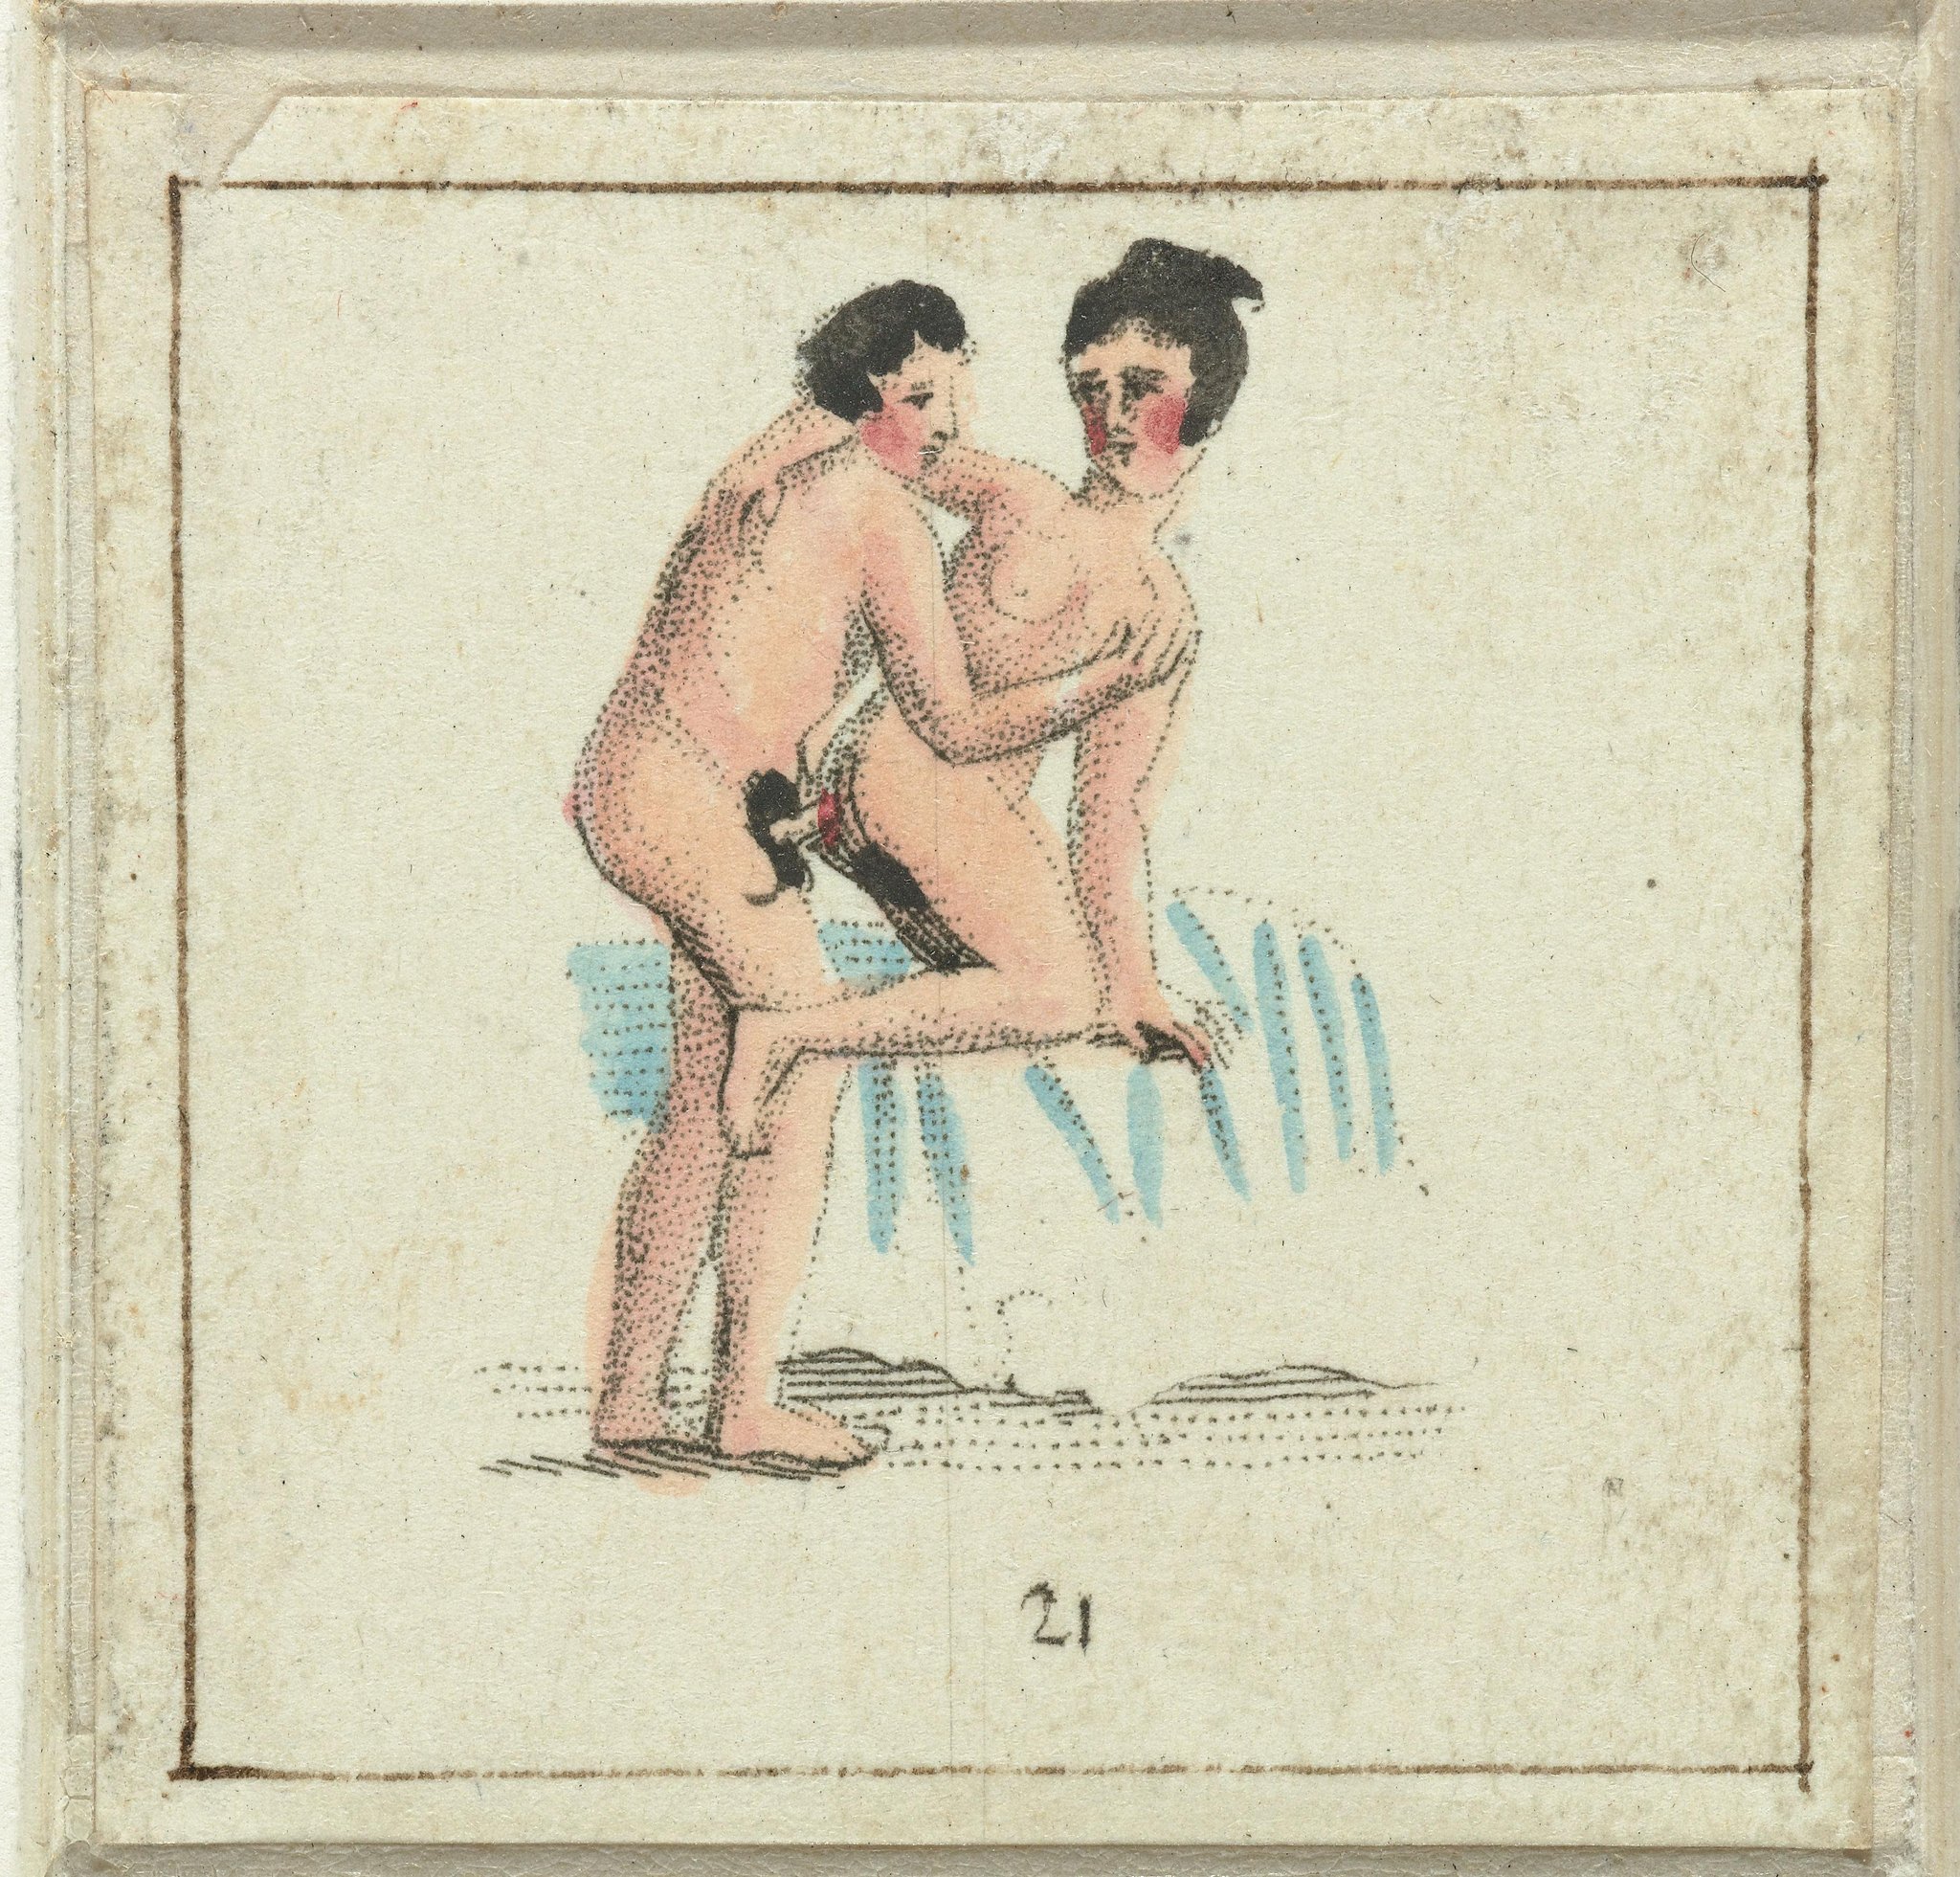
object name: print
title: Acht erotische scène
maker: Anonymous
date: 1750-1850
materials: paper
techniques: etching, hand coloring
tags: man and woman cohabiting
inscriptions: number: ‘21’